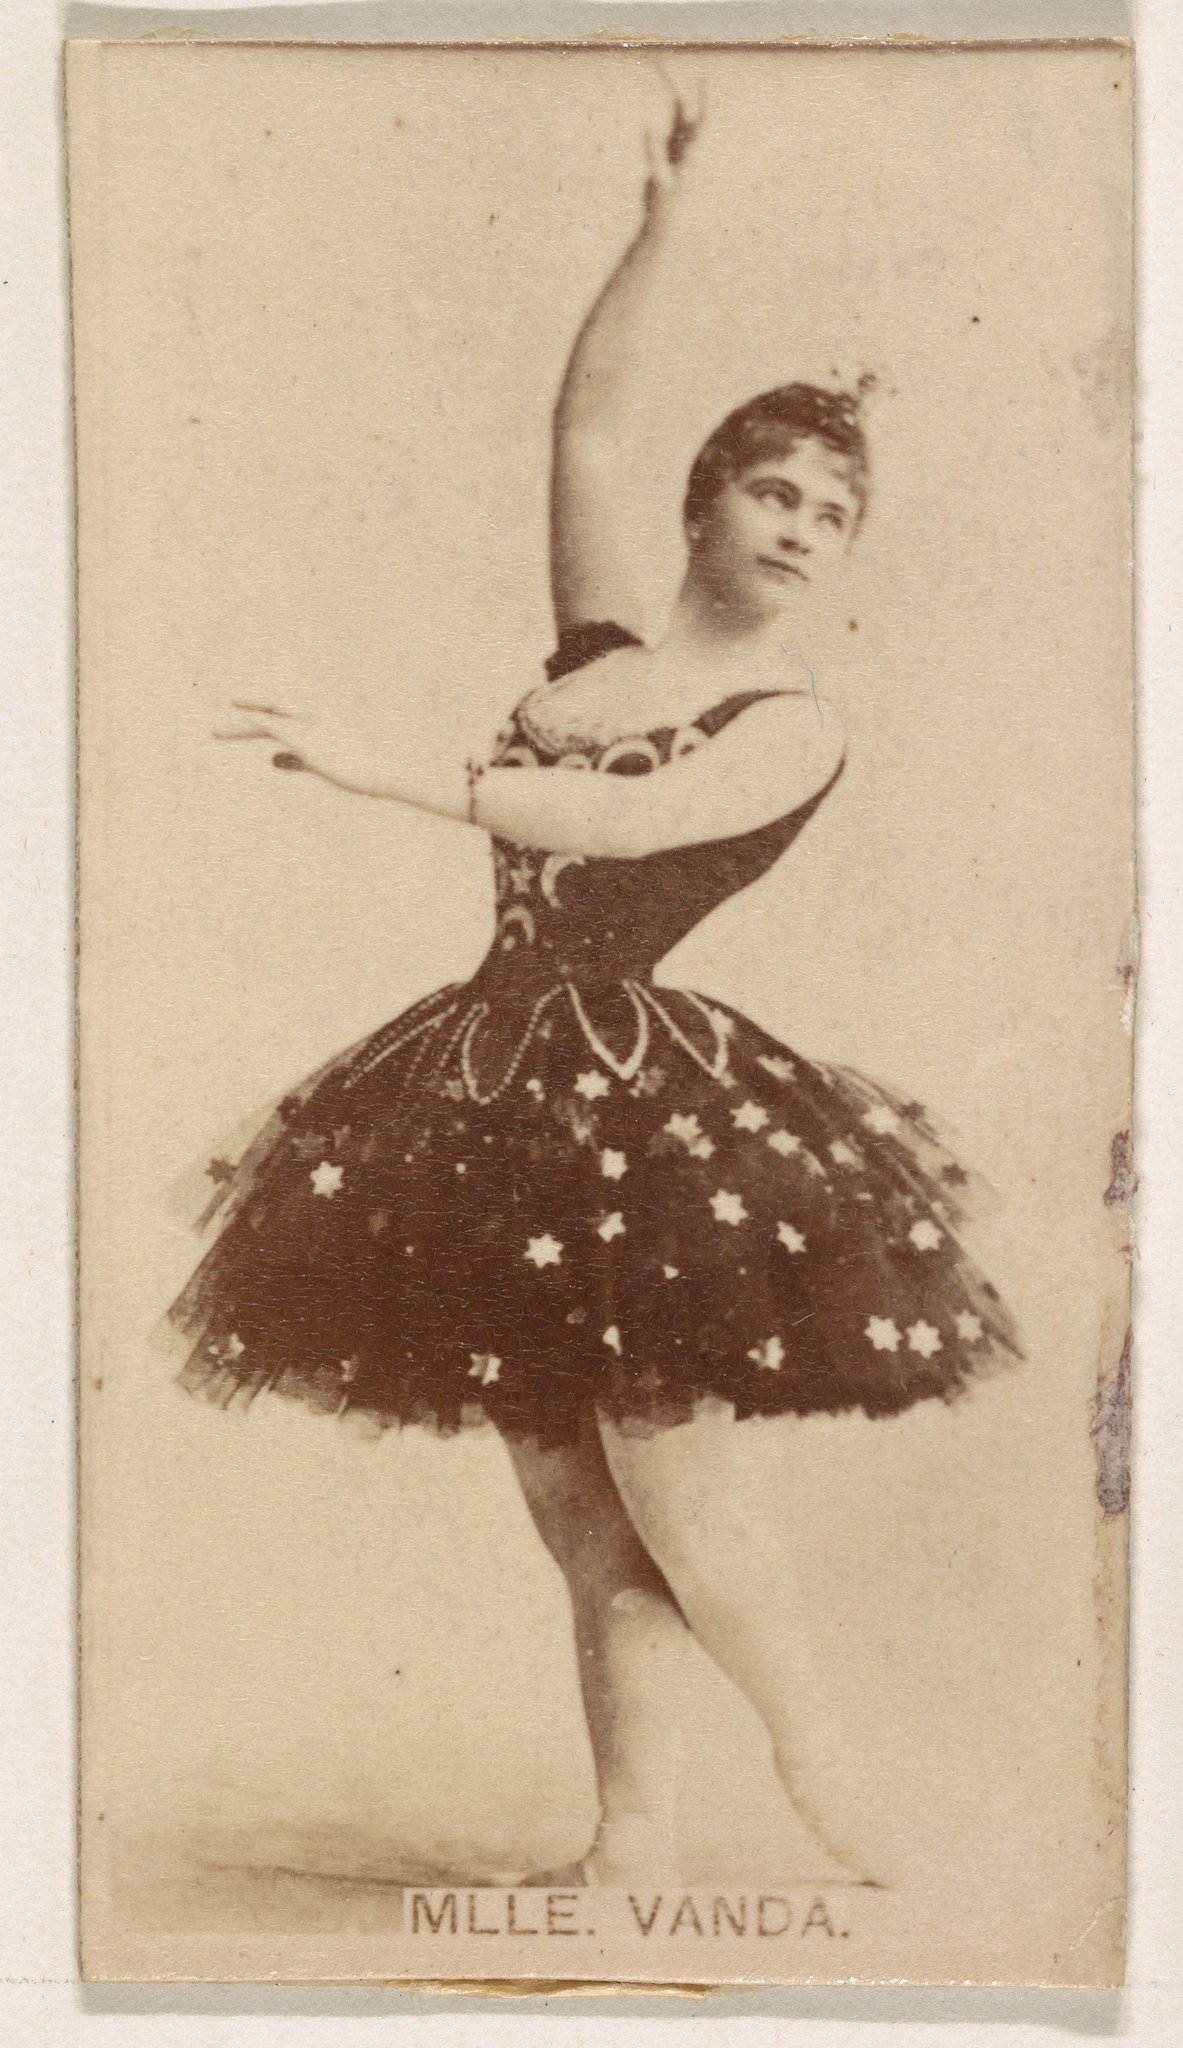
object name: photograph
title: Mlle. Vanda, from the Actresses series (N245) issued by Kinney Brothers to promote Sweet Caporal Cigarettes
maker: kinney brothers tobacco company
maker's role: publisher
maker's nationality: american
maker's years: 1869-2011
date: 1890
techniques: albumen silver print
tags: portraits,women,actresses